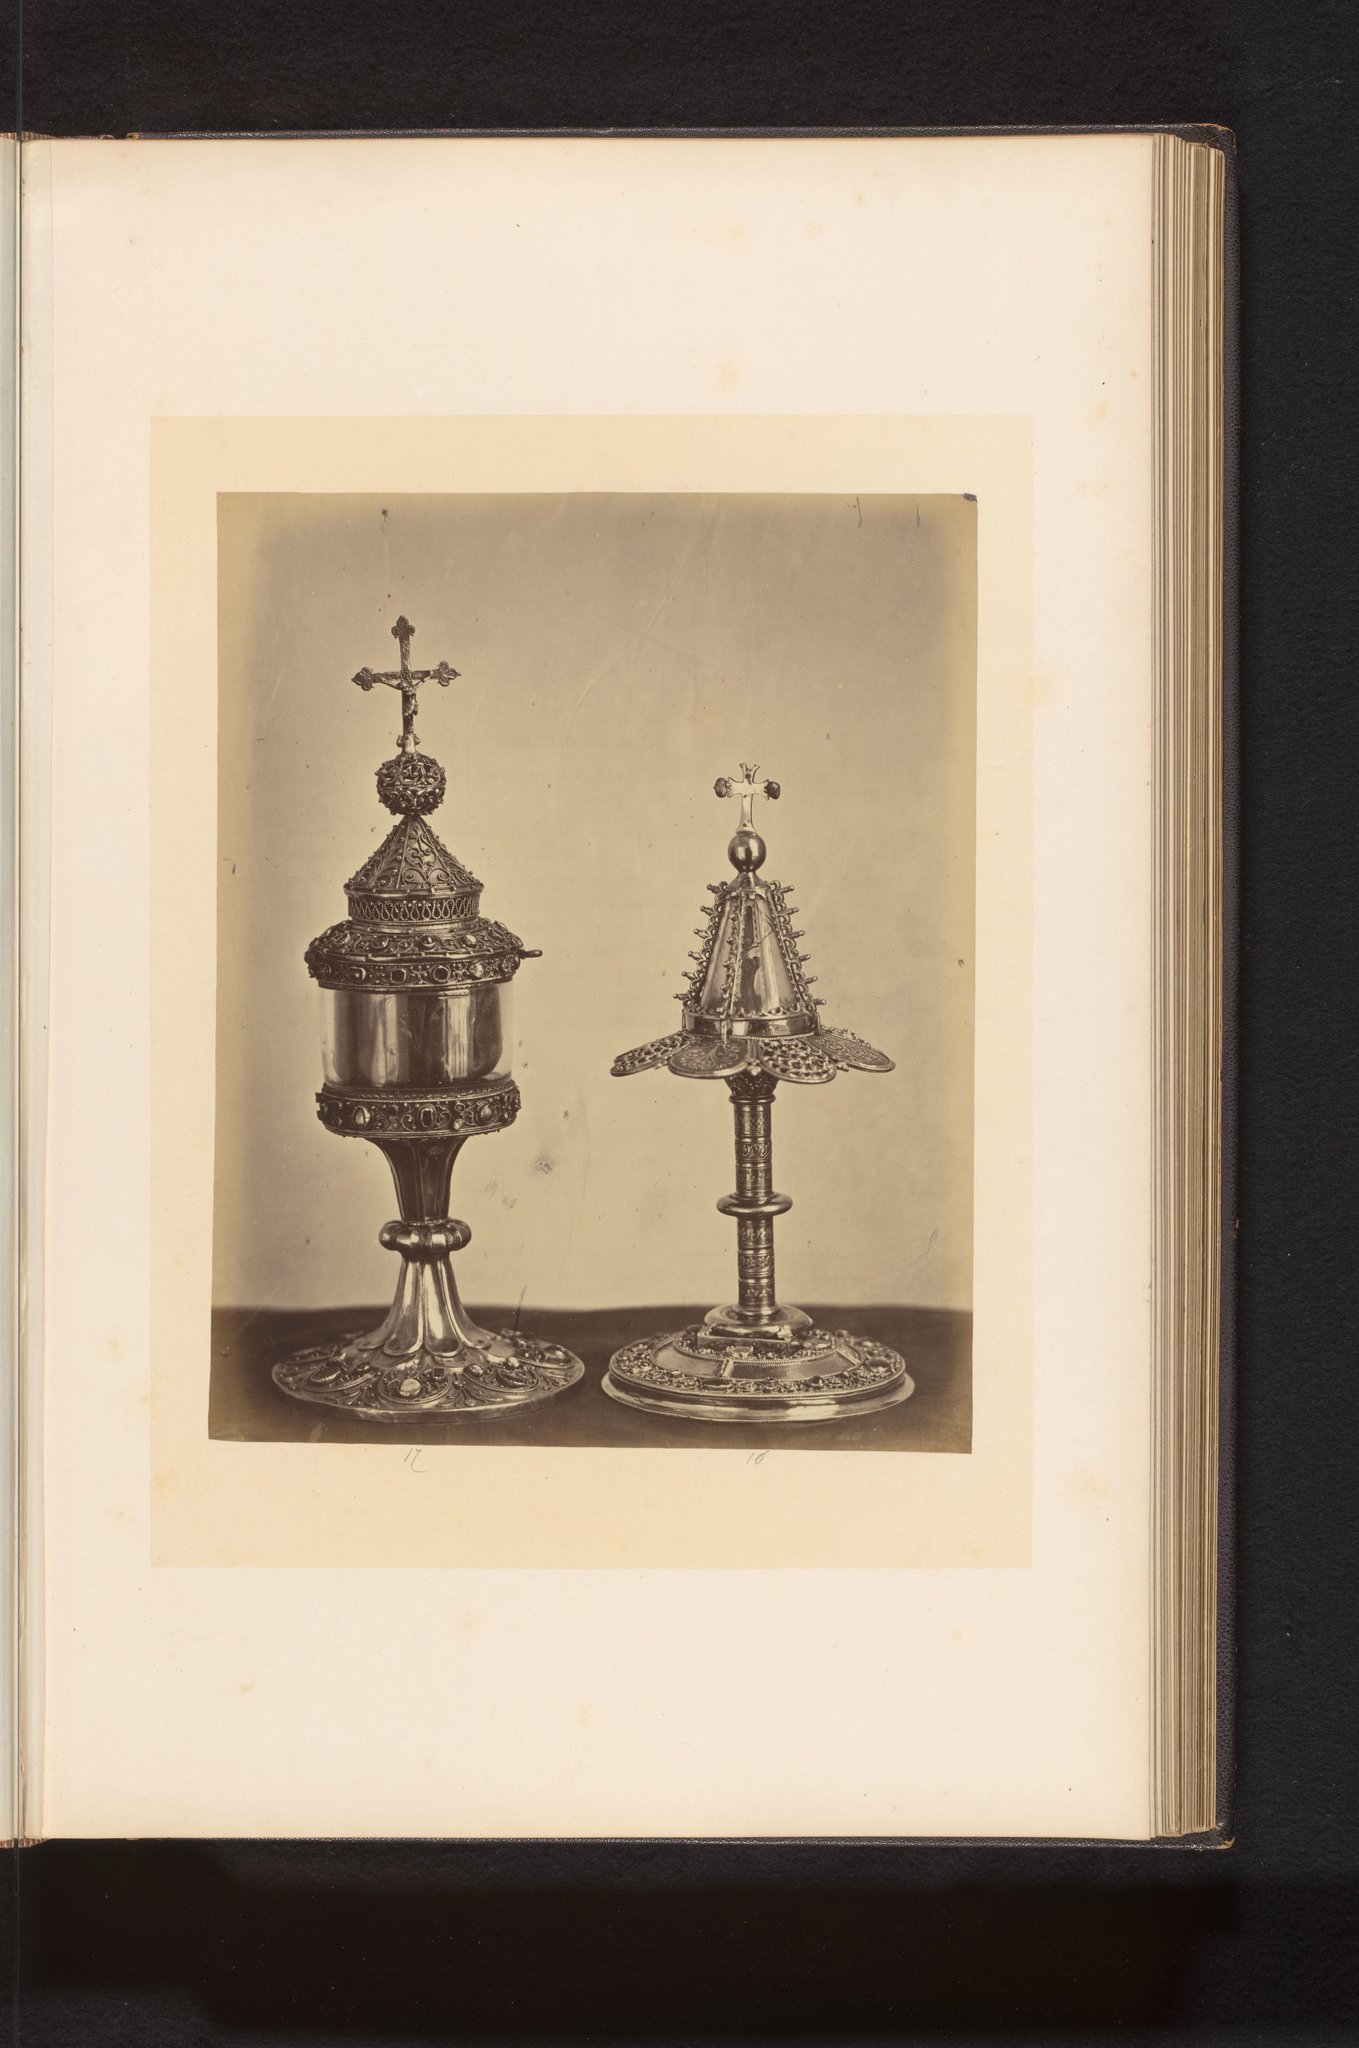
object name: photograph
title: Twee monstransen van metaal, opgesteld op een tentoonstelling over religieuze objecten uit de middeleeuwen en renaissance in 1864 in Mechelen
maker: joseph maes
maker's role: fotograaf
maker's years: 1838-1908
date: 1864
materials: photographic support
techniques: albumen print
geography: mechelen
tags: ostensorium, monstrance, relics (and reliquaries), mechelen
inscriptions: number: ‘17 - 16’